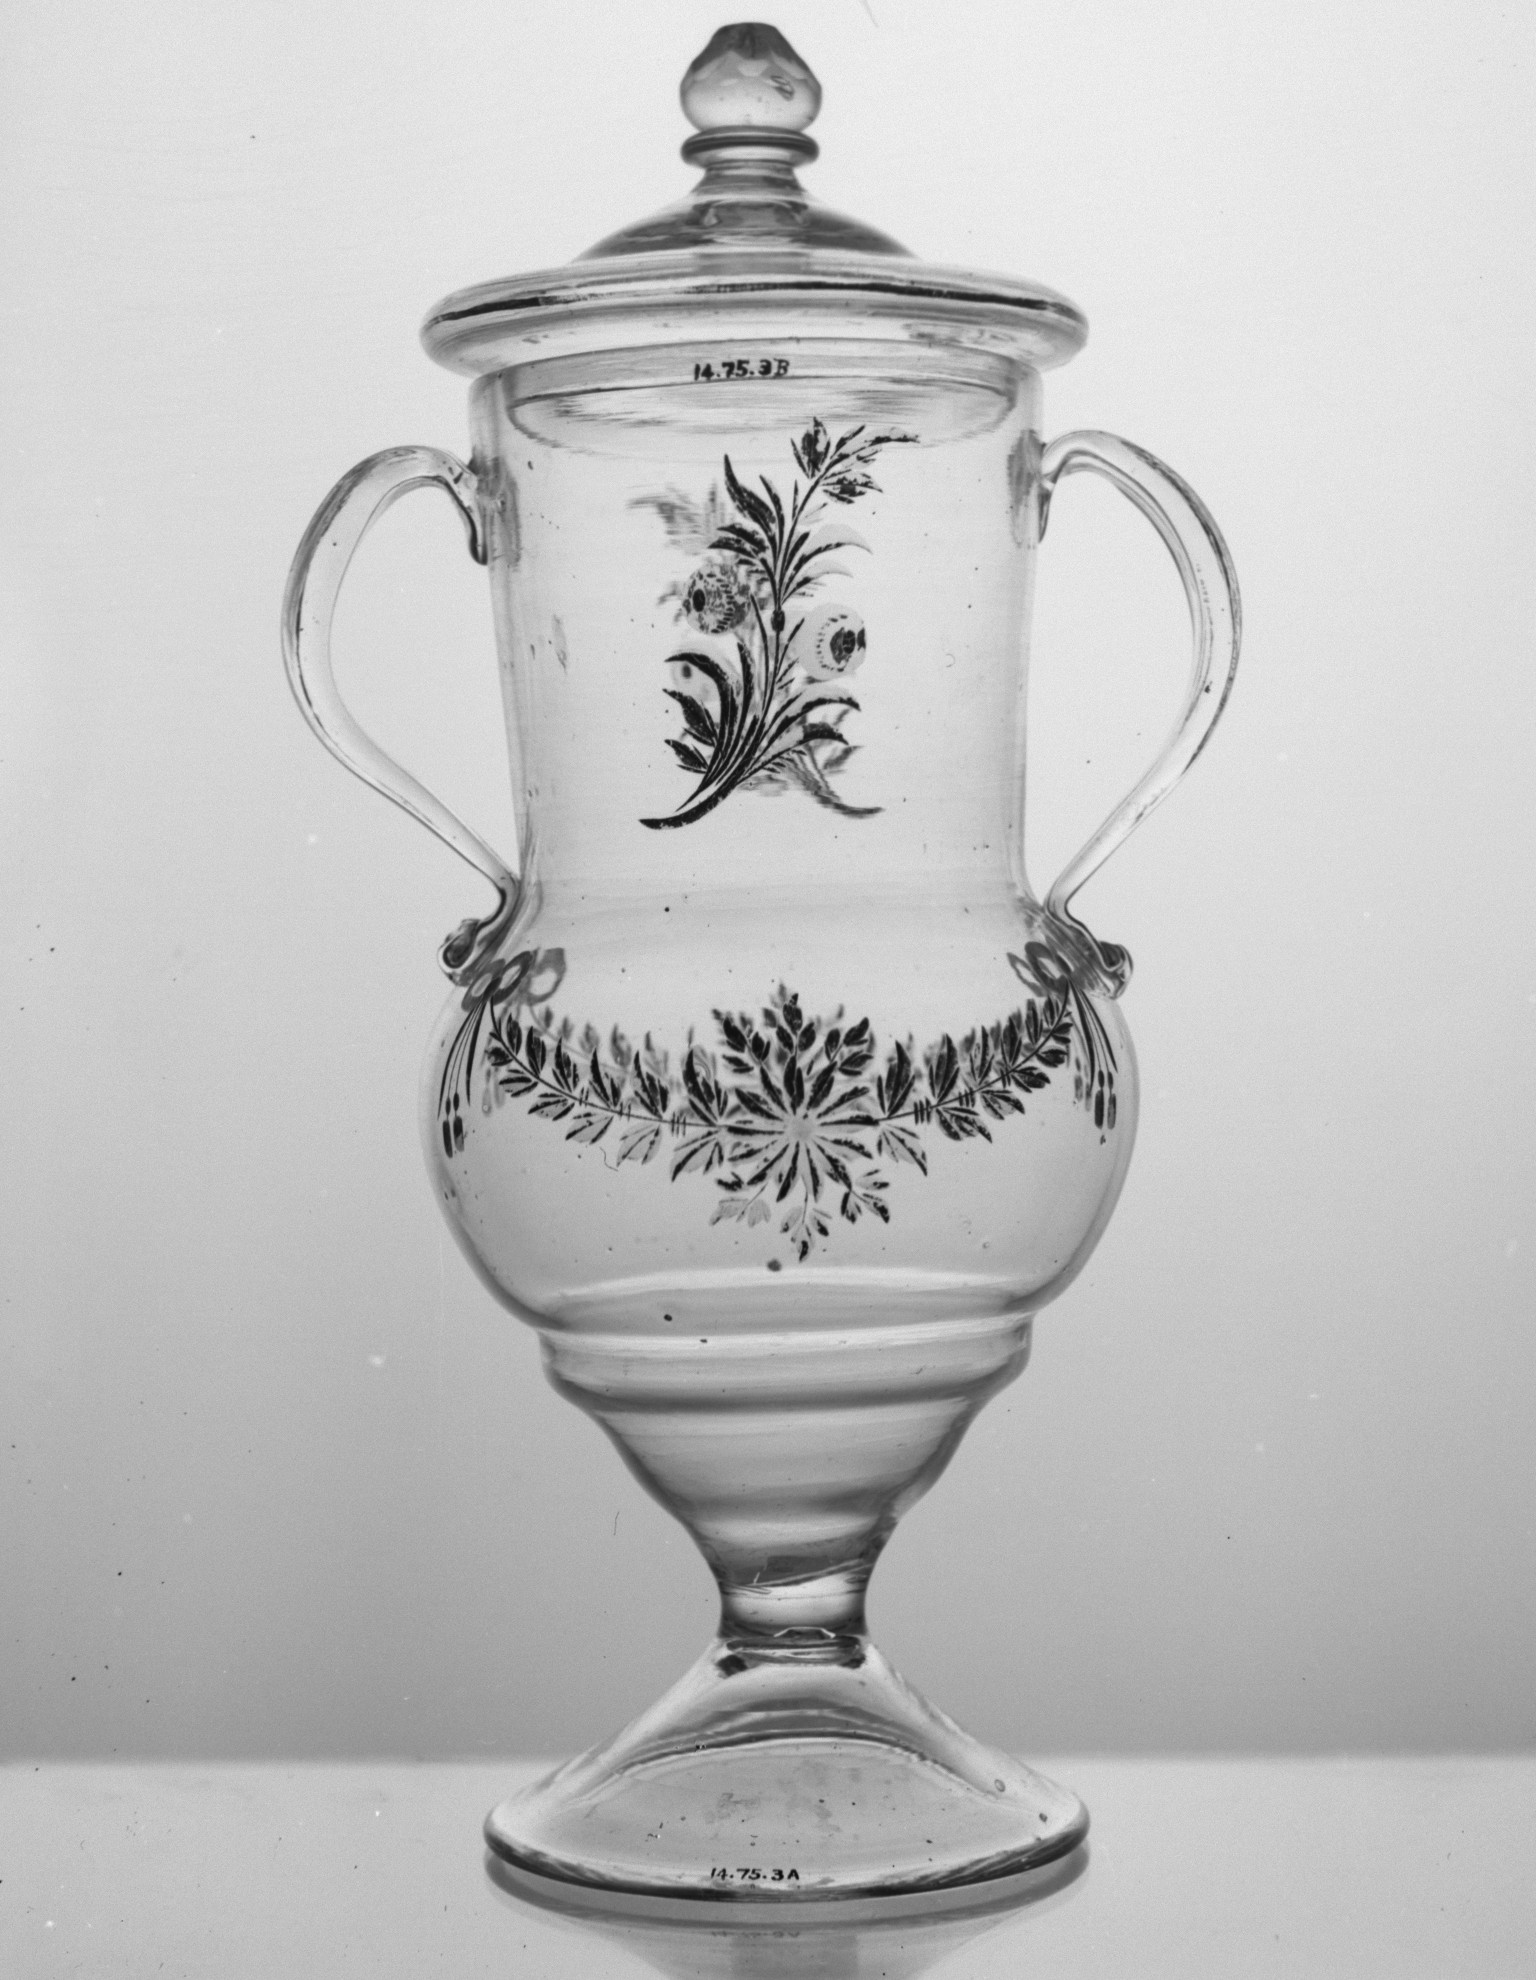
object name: vase with cover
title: Two-handled vase with cover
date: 1767-1800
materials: glass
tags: flowers